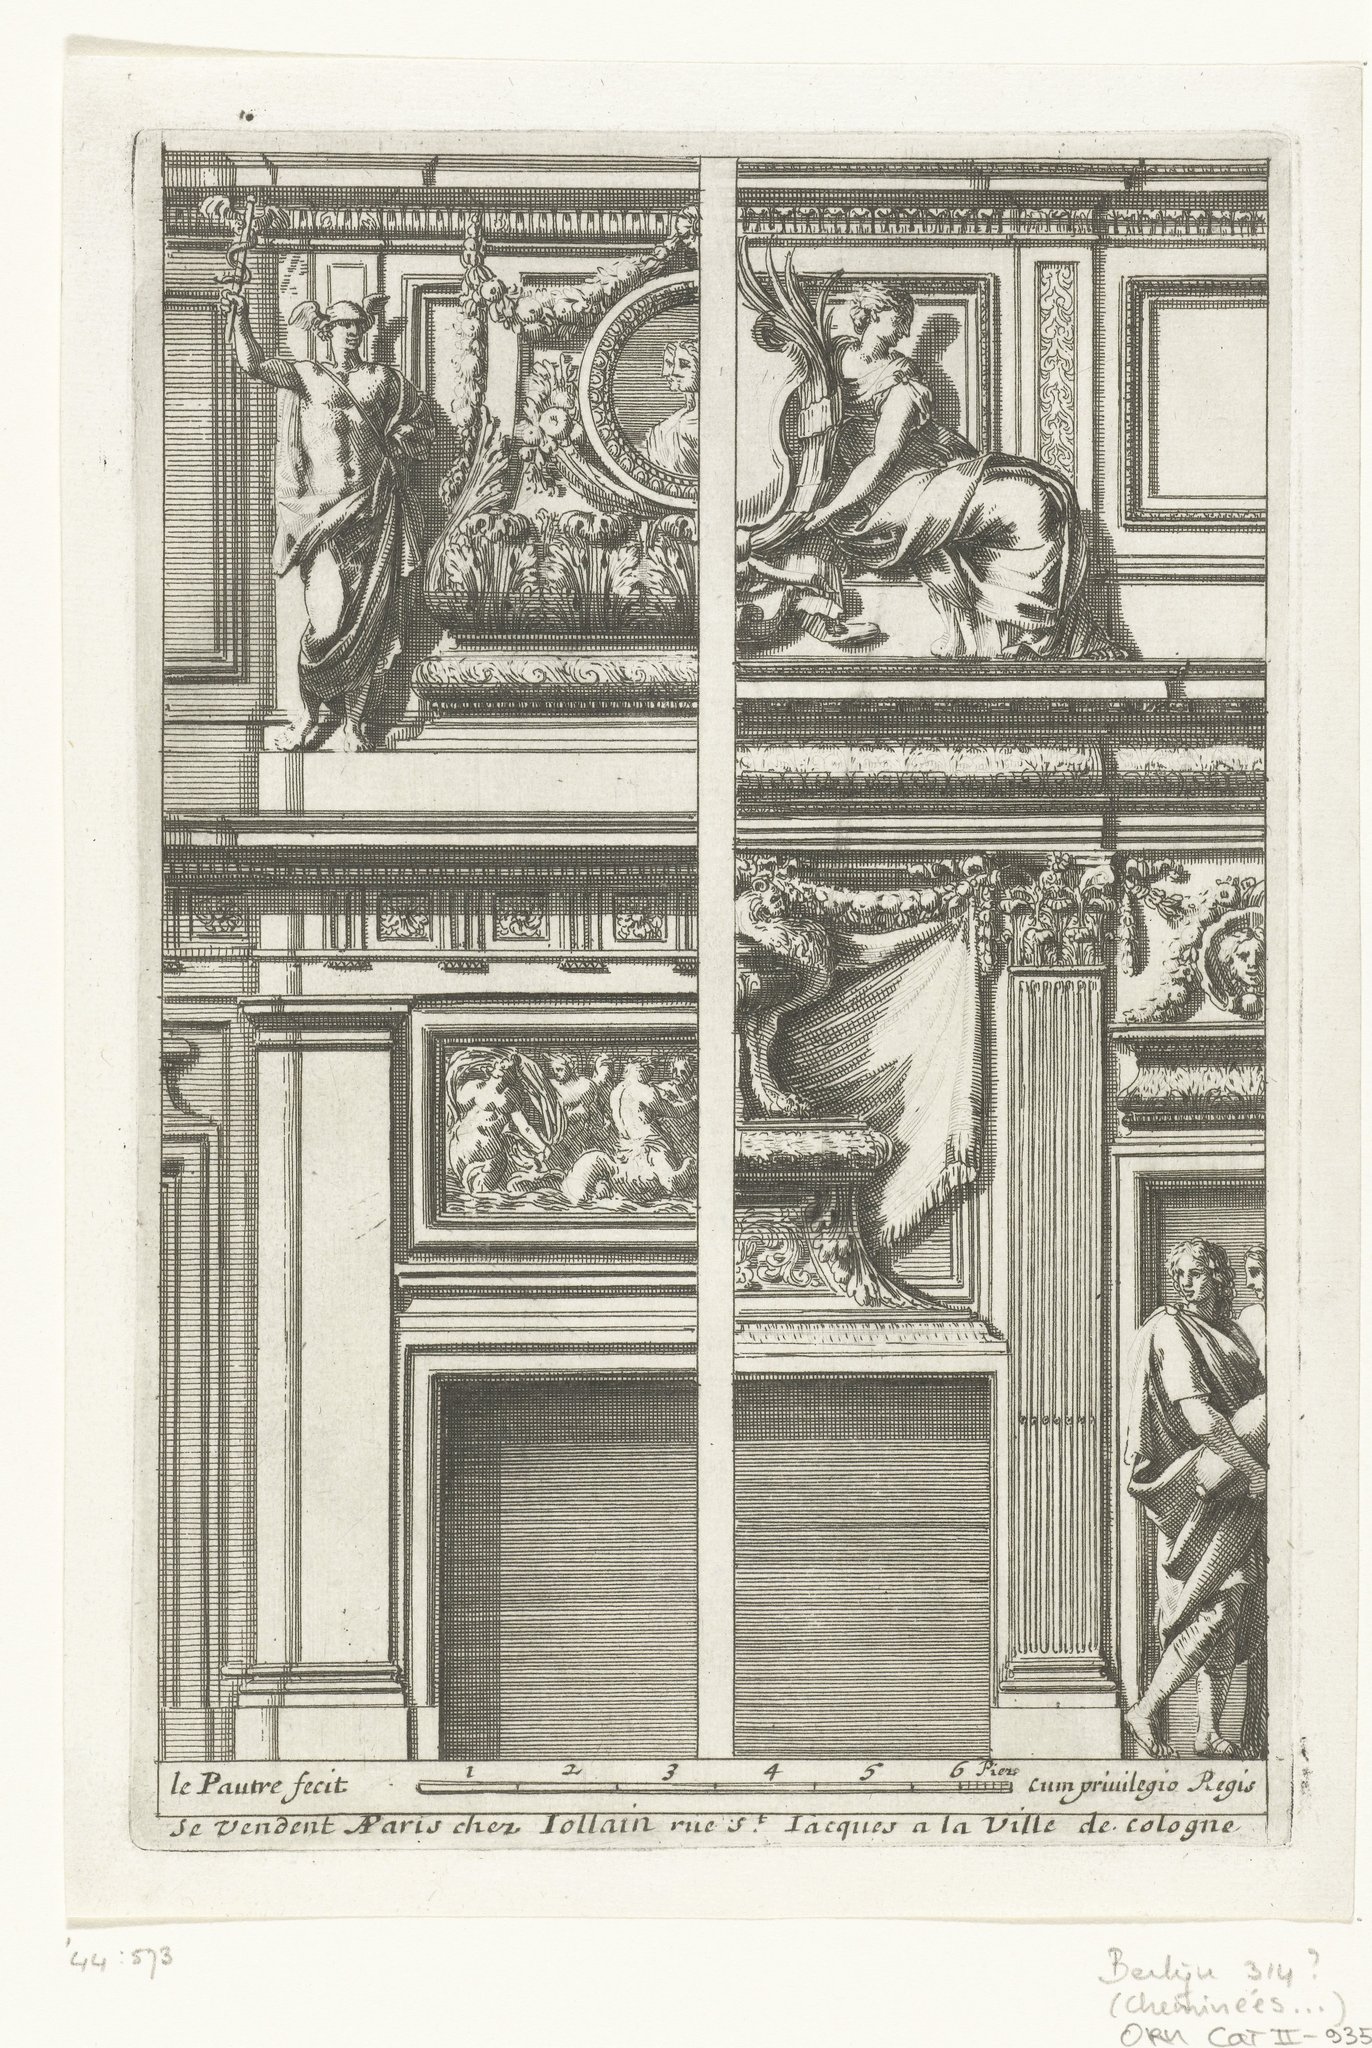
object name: ornament print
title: Cheminées a l'Italienne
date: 1665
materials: paper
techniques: etching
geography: france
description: Links staat een beeld van Mercurius. Uit serie van 6 bladen.